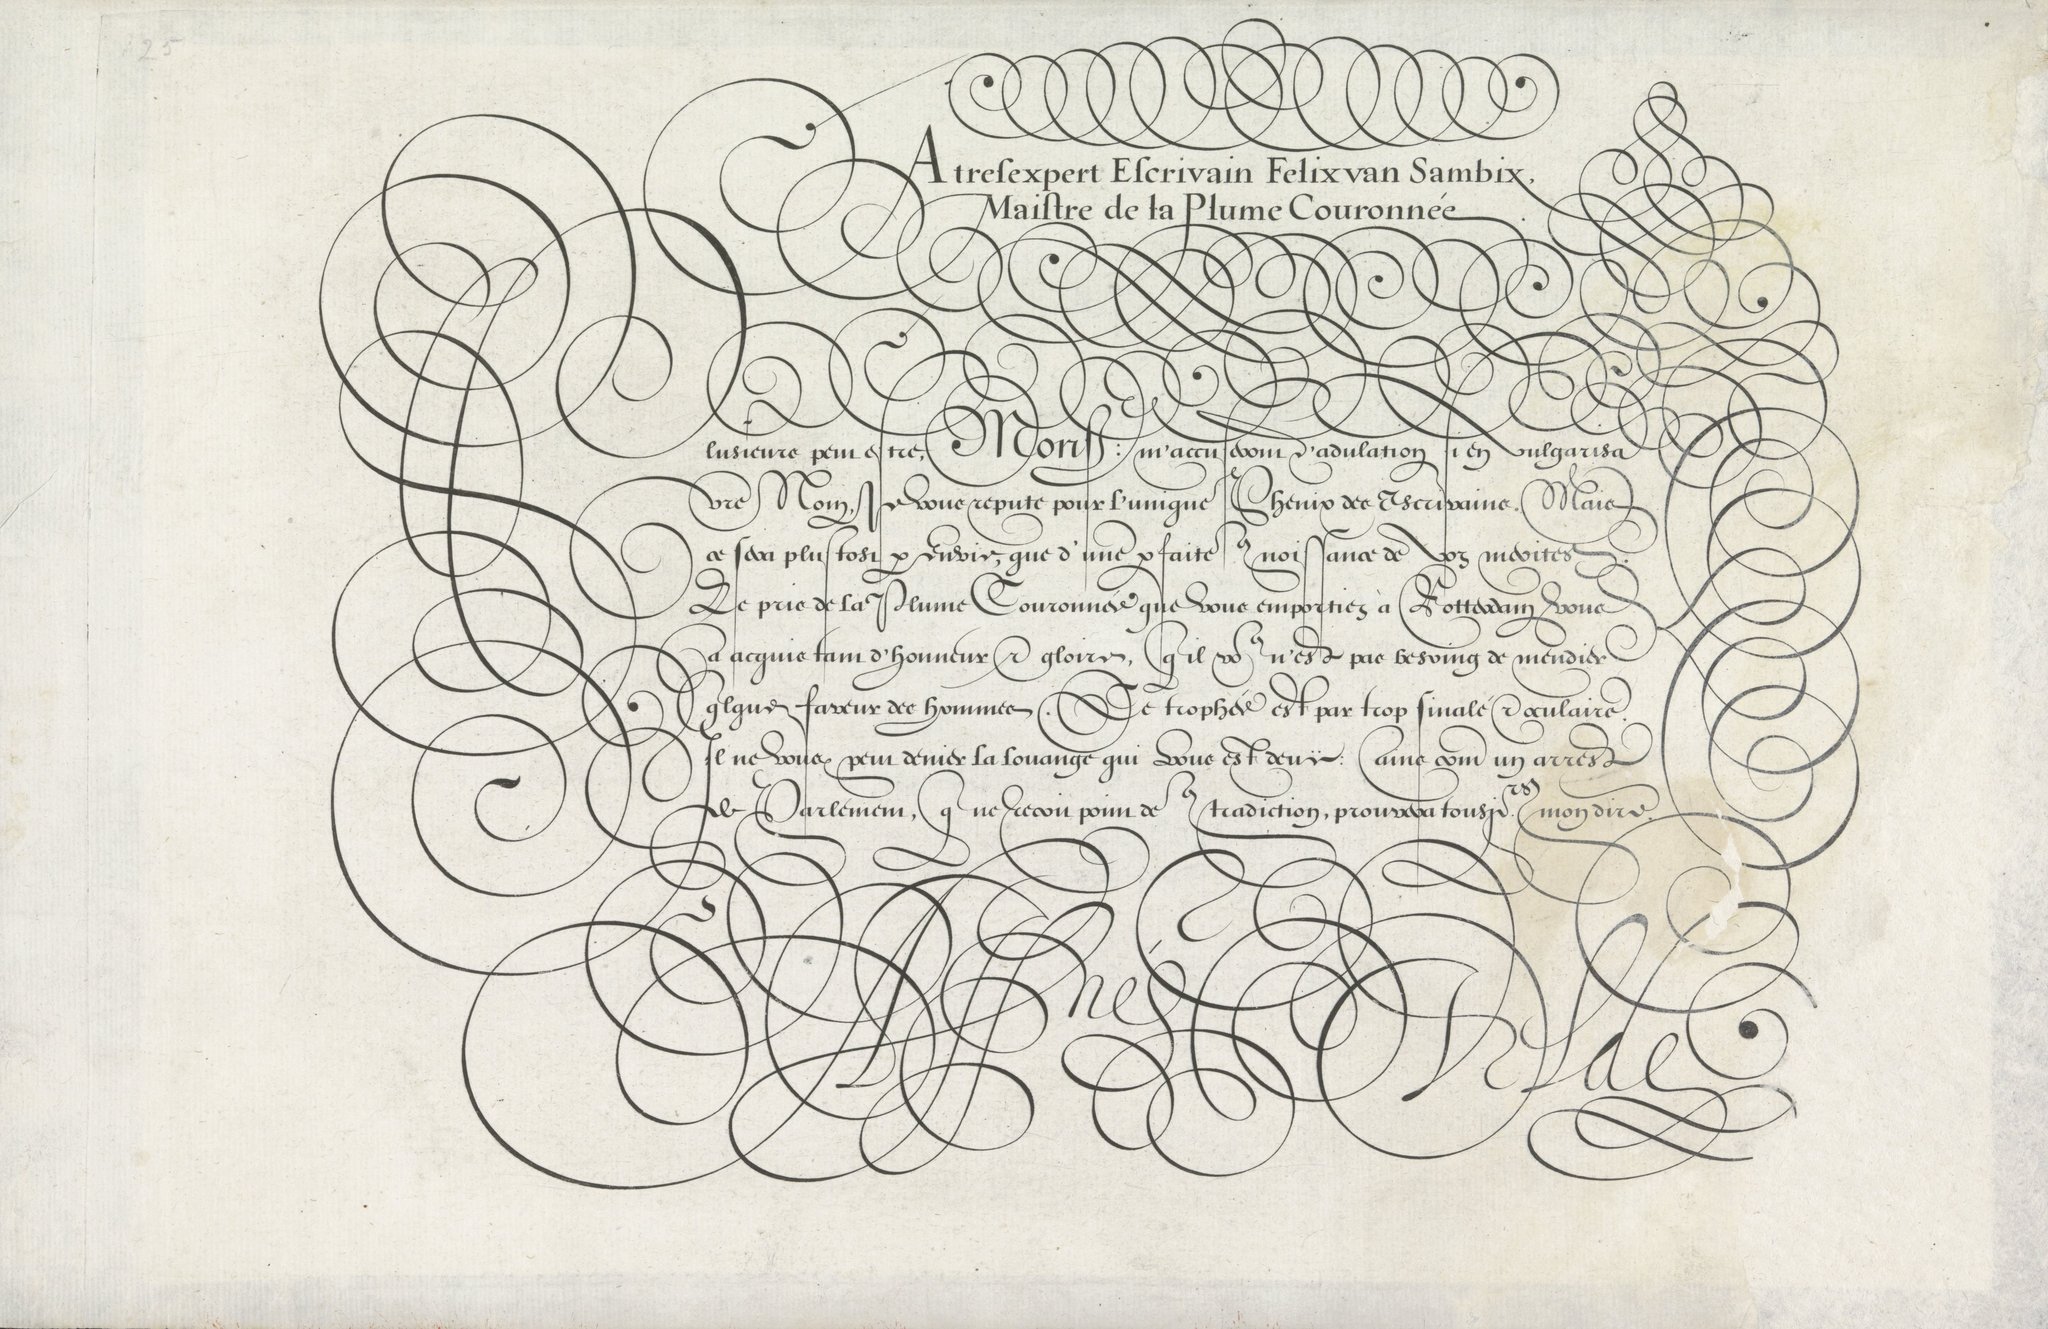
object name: ornament print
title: Spieghel der schrijfkonste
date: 1605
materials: paper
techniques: engraving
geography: rotterdam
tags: calligraphy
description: Schrijfvoorbeeld met de aanhef: A tres expert escrivain Felix van Sambix. Maistre de la Plume Couronnée. Daaronder in een andere letter een initiaal P en acht regels tekst in het Frans: Plusieure peut estre ... Onderaan: Aisné Velde. De tekst is omlijst door krulwerk. De prent maakt deel uit van een album.